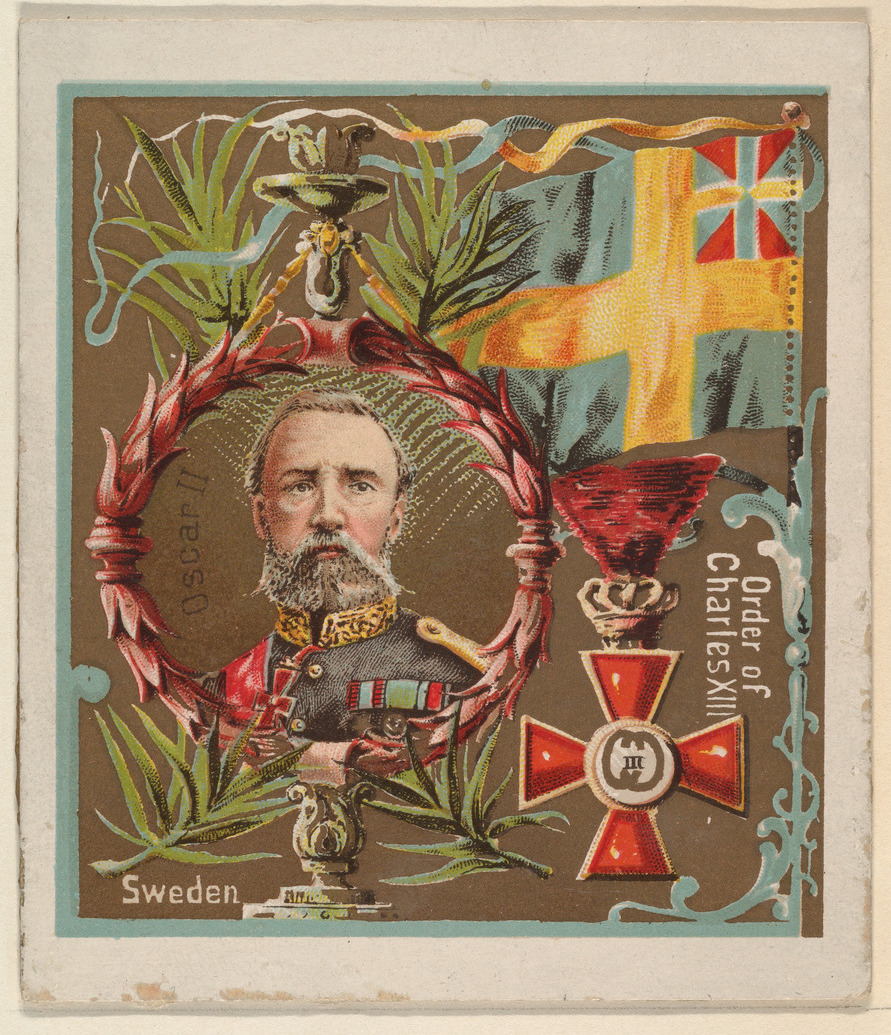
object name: print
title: Sweden, from the International Cards series (N238), issued by Kinney Bros.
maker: kinney brothers tobacco company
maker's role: publisher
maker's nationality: american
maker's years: 1869-2011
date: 1888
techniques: color lithograph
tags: men,flags